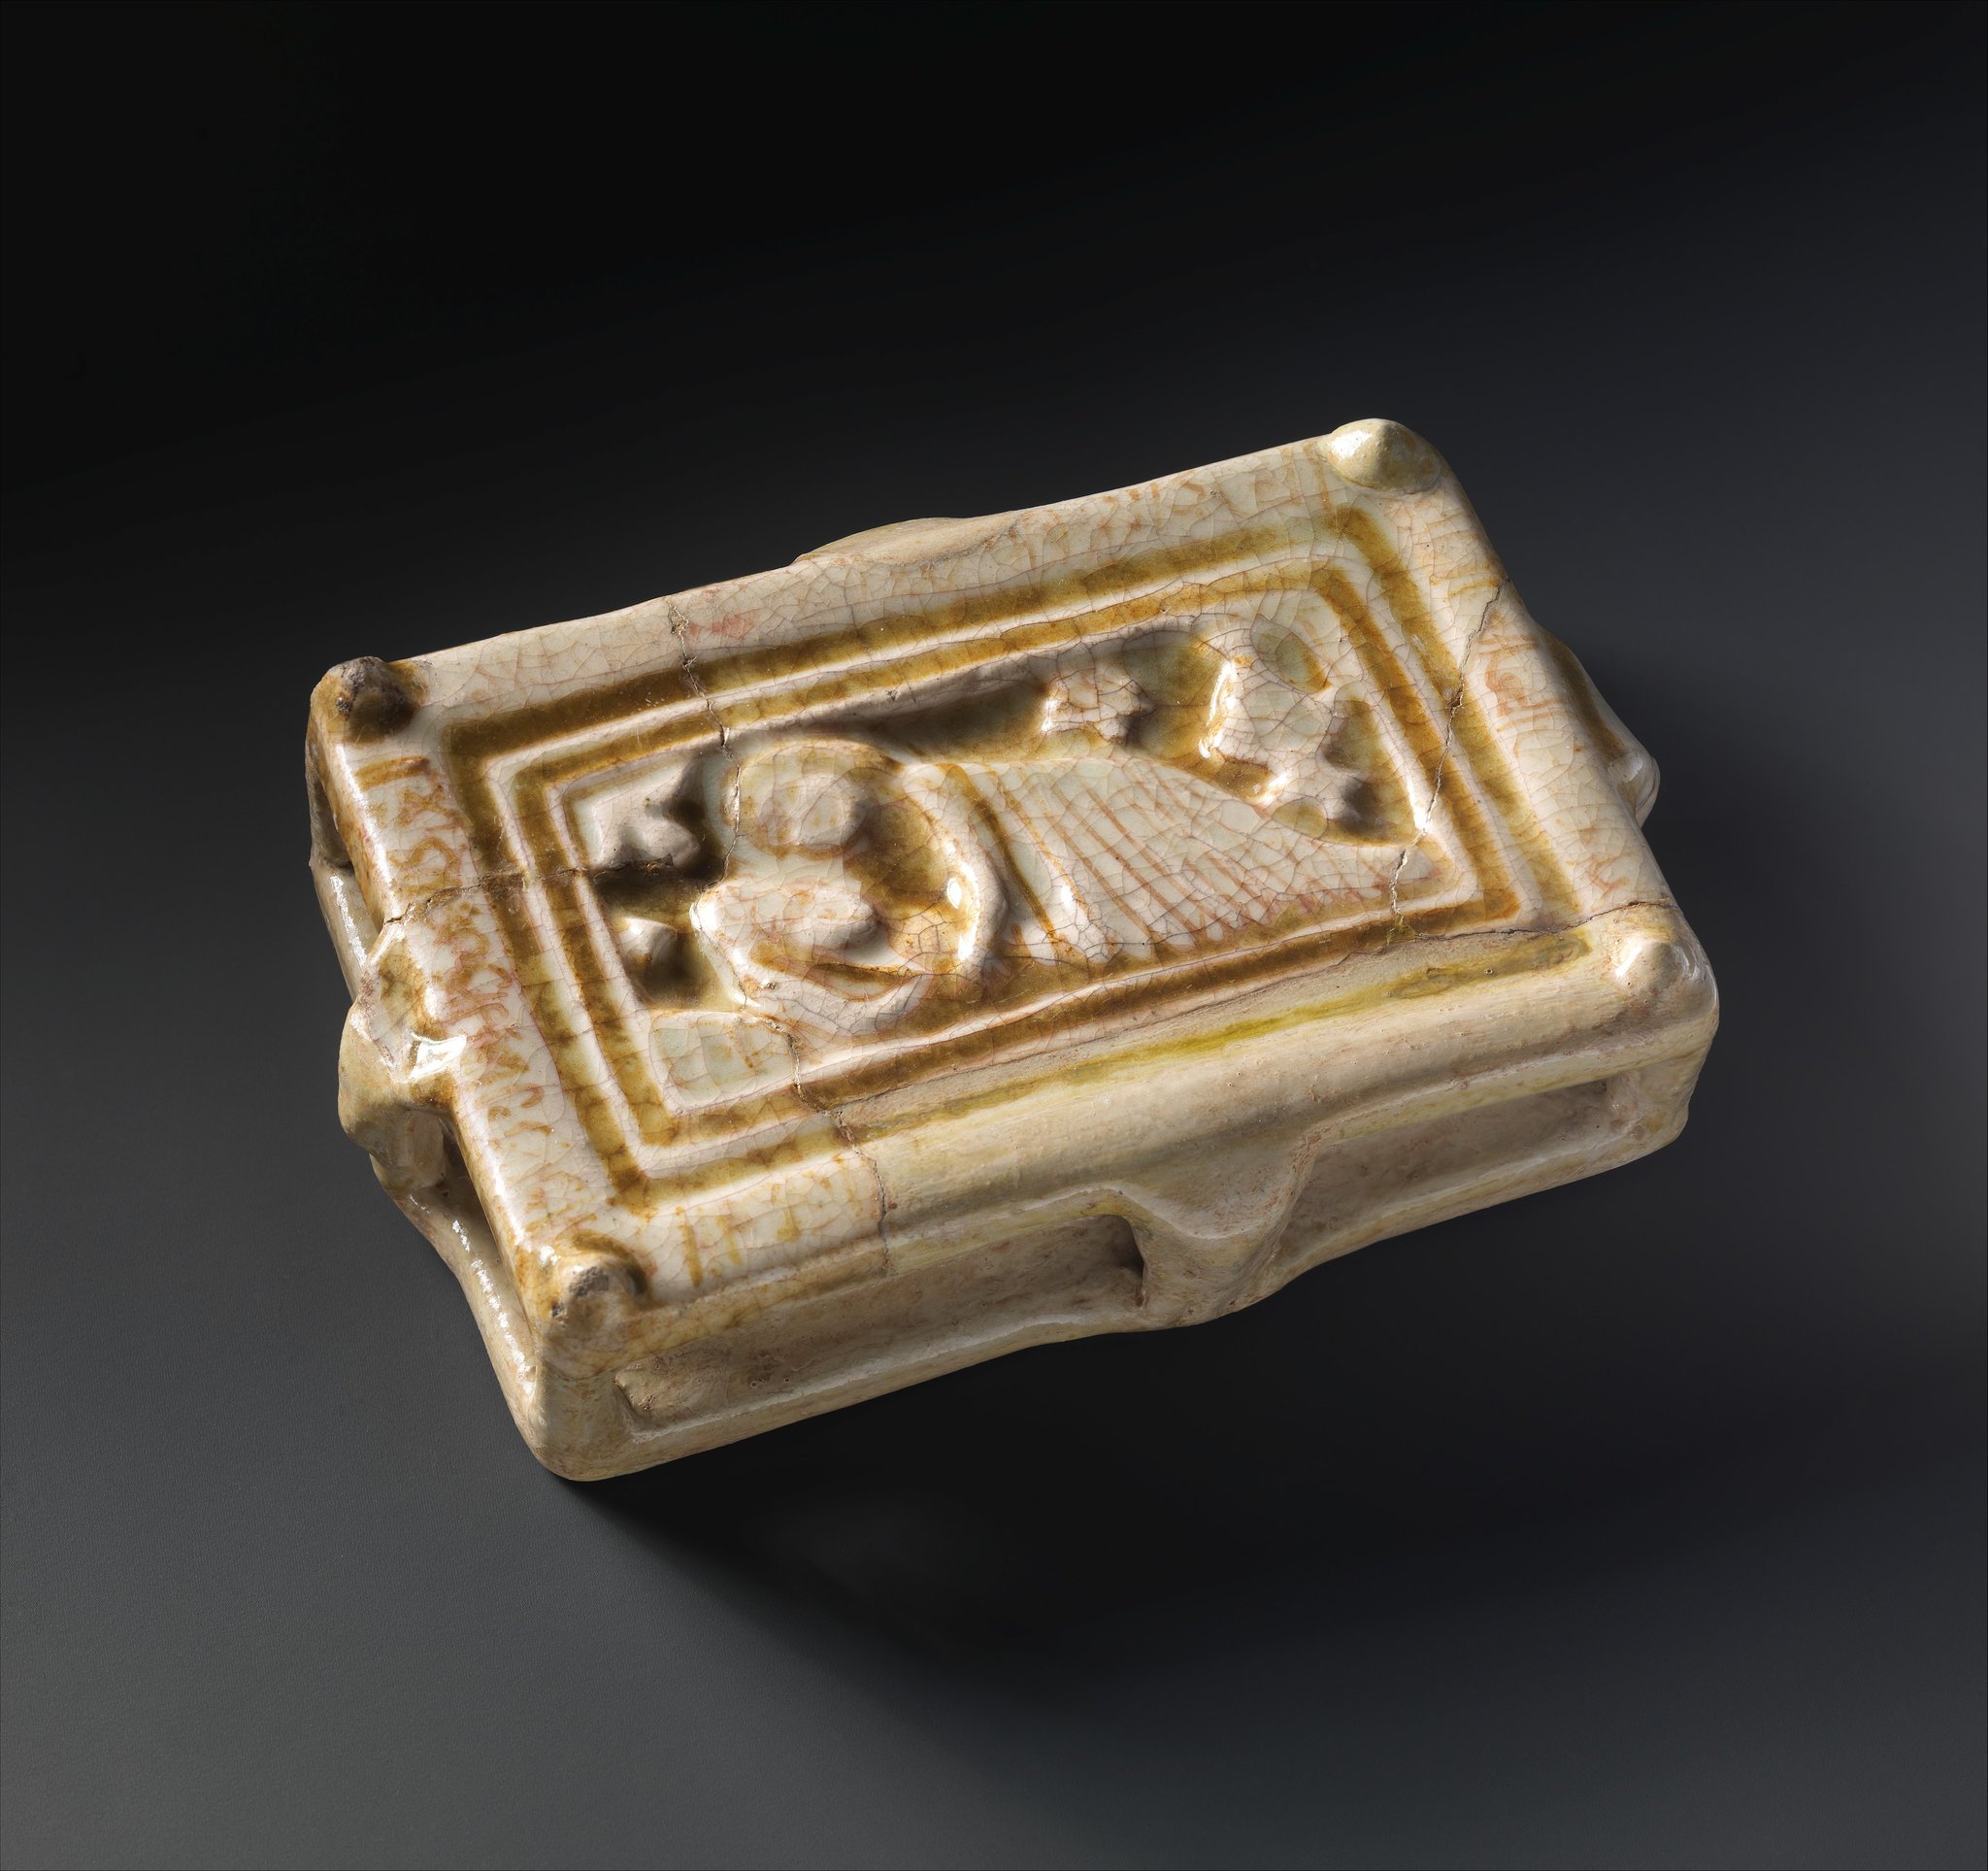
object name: house model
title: Model of a House with Amorous Couple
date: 1101-1233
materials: stonepaste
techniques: glazing, luster painting, molding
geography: iran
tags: houses,couples